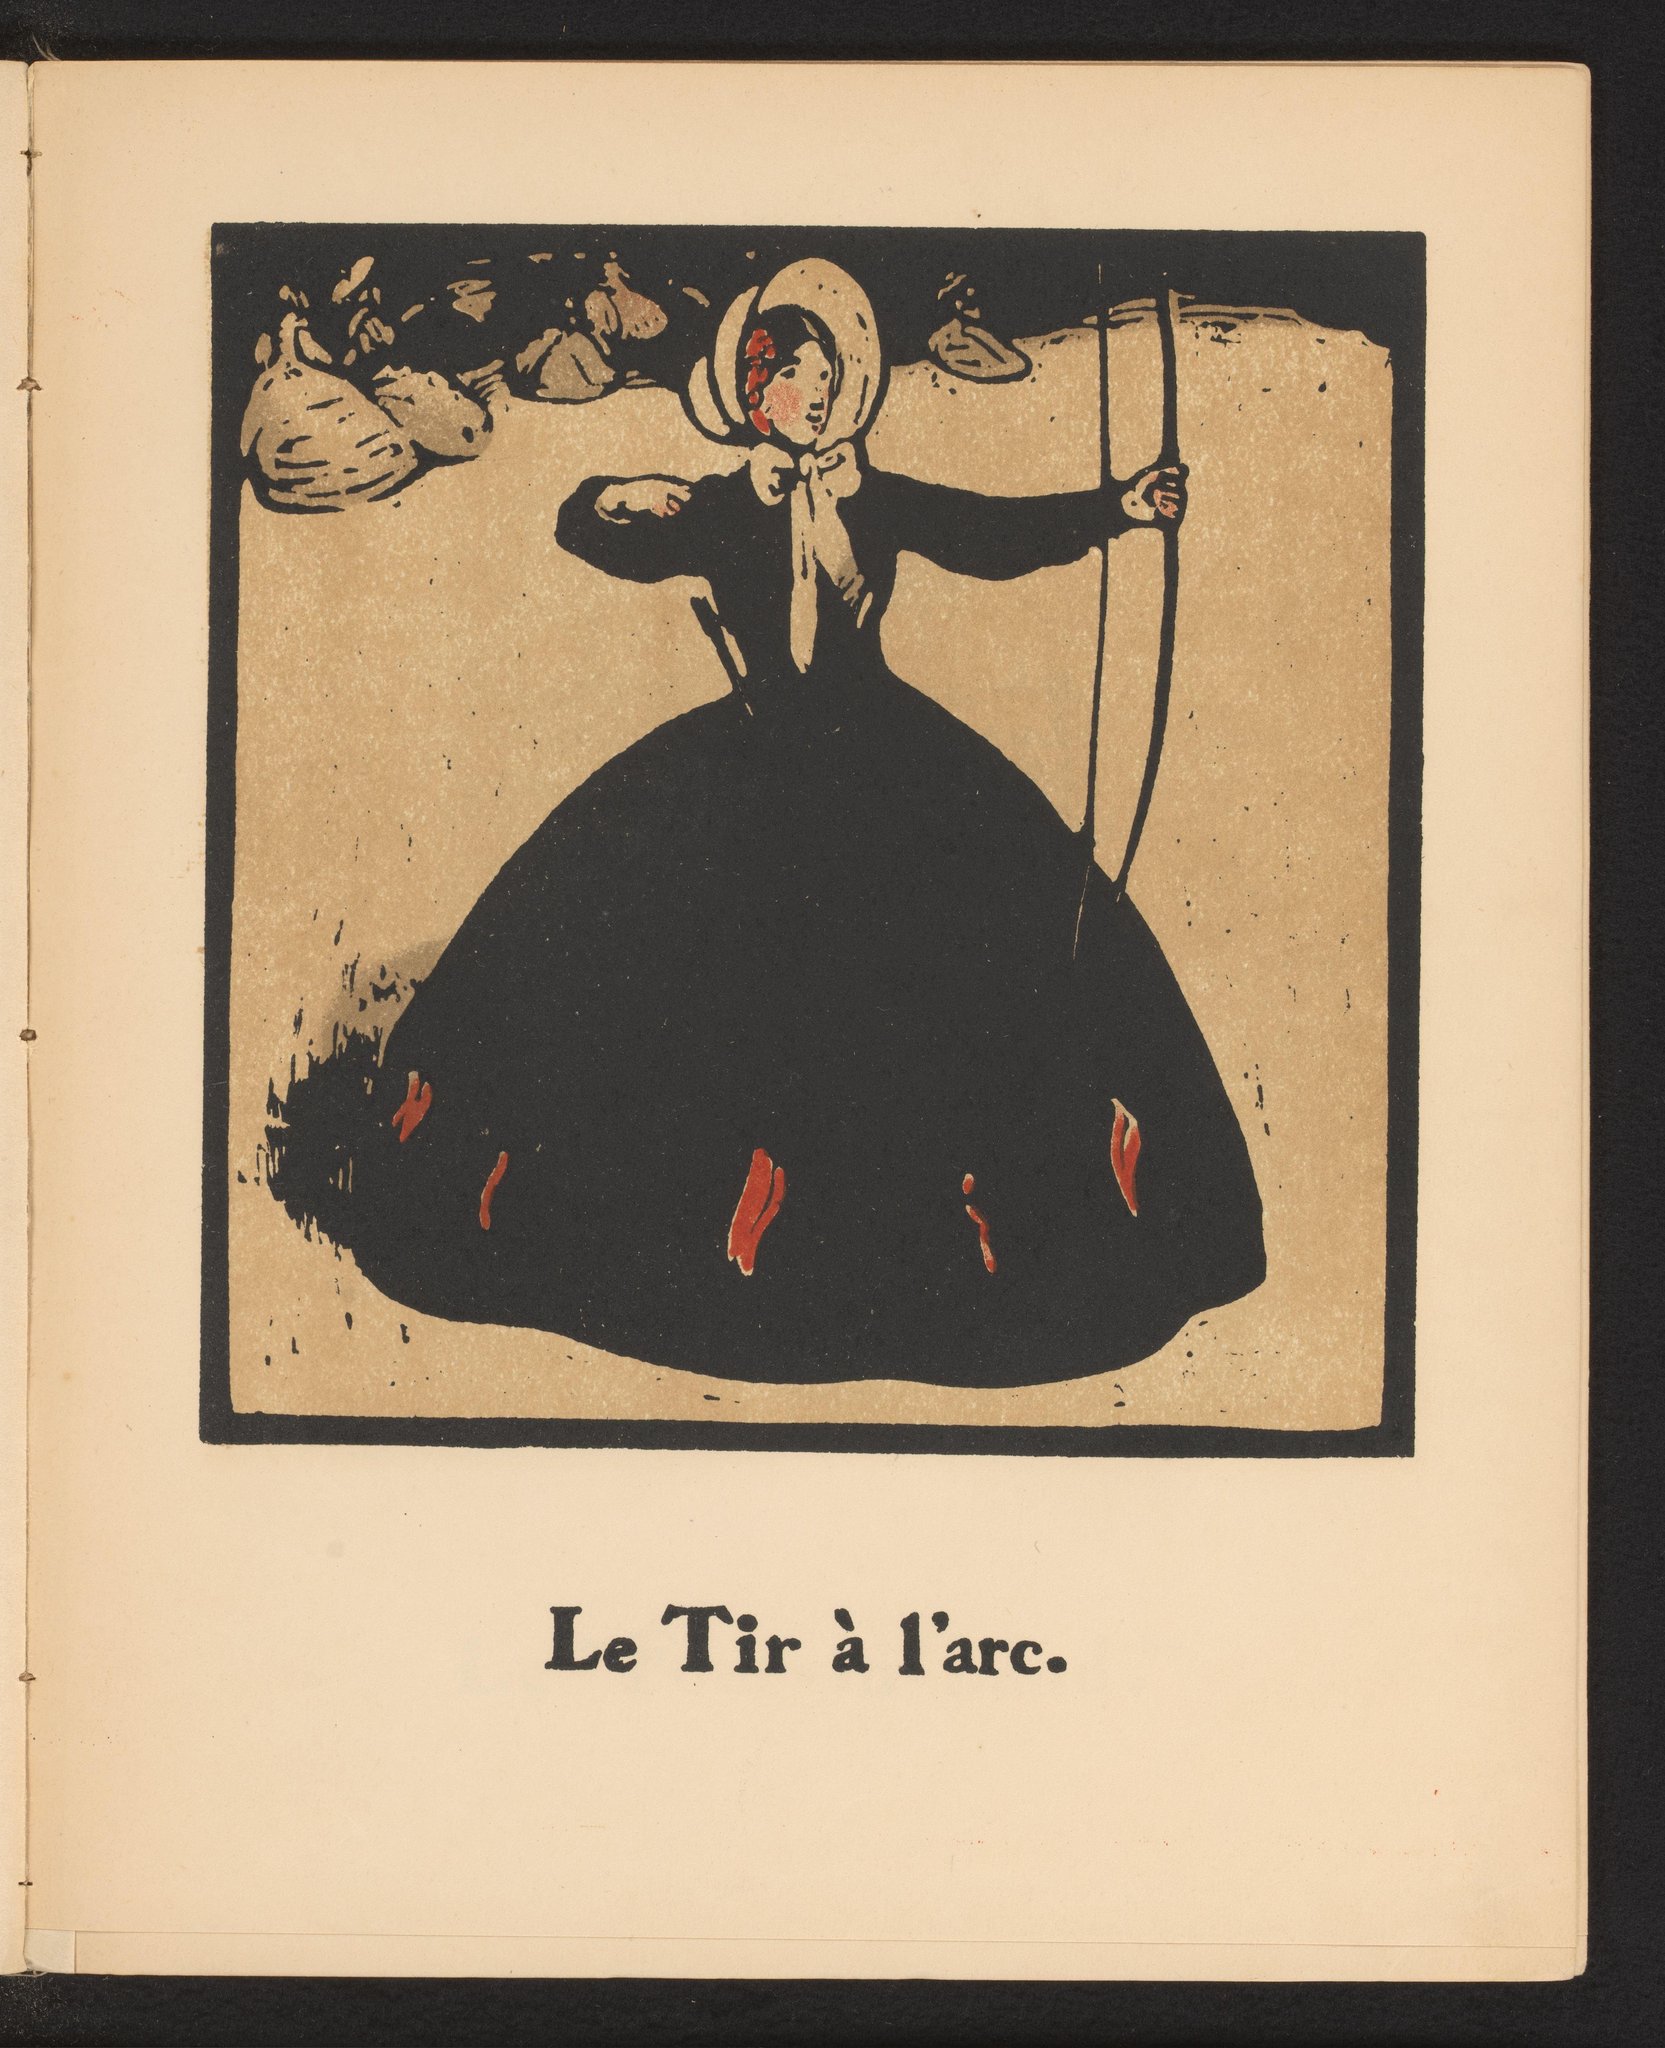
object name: print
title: Almanak met twaalf sporten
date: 1898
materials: paper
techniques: lithograph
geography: paris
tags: calendar, almanac, archer's weapons: arrow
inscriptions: : ‘Ouût./ Dimanche - 7 14 21 28/ Lundi 1 8 15 (...)’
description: Prent maakt deel uit van een boek. Illustratie bij kalendermaand op tegenoverliggende blad.